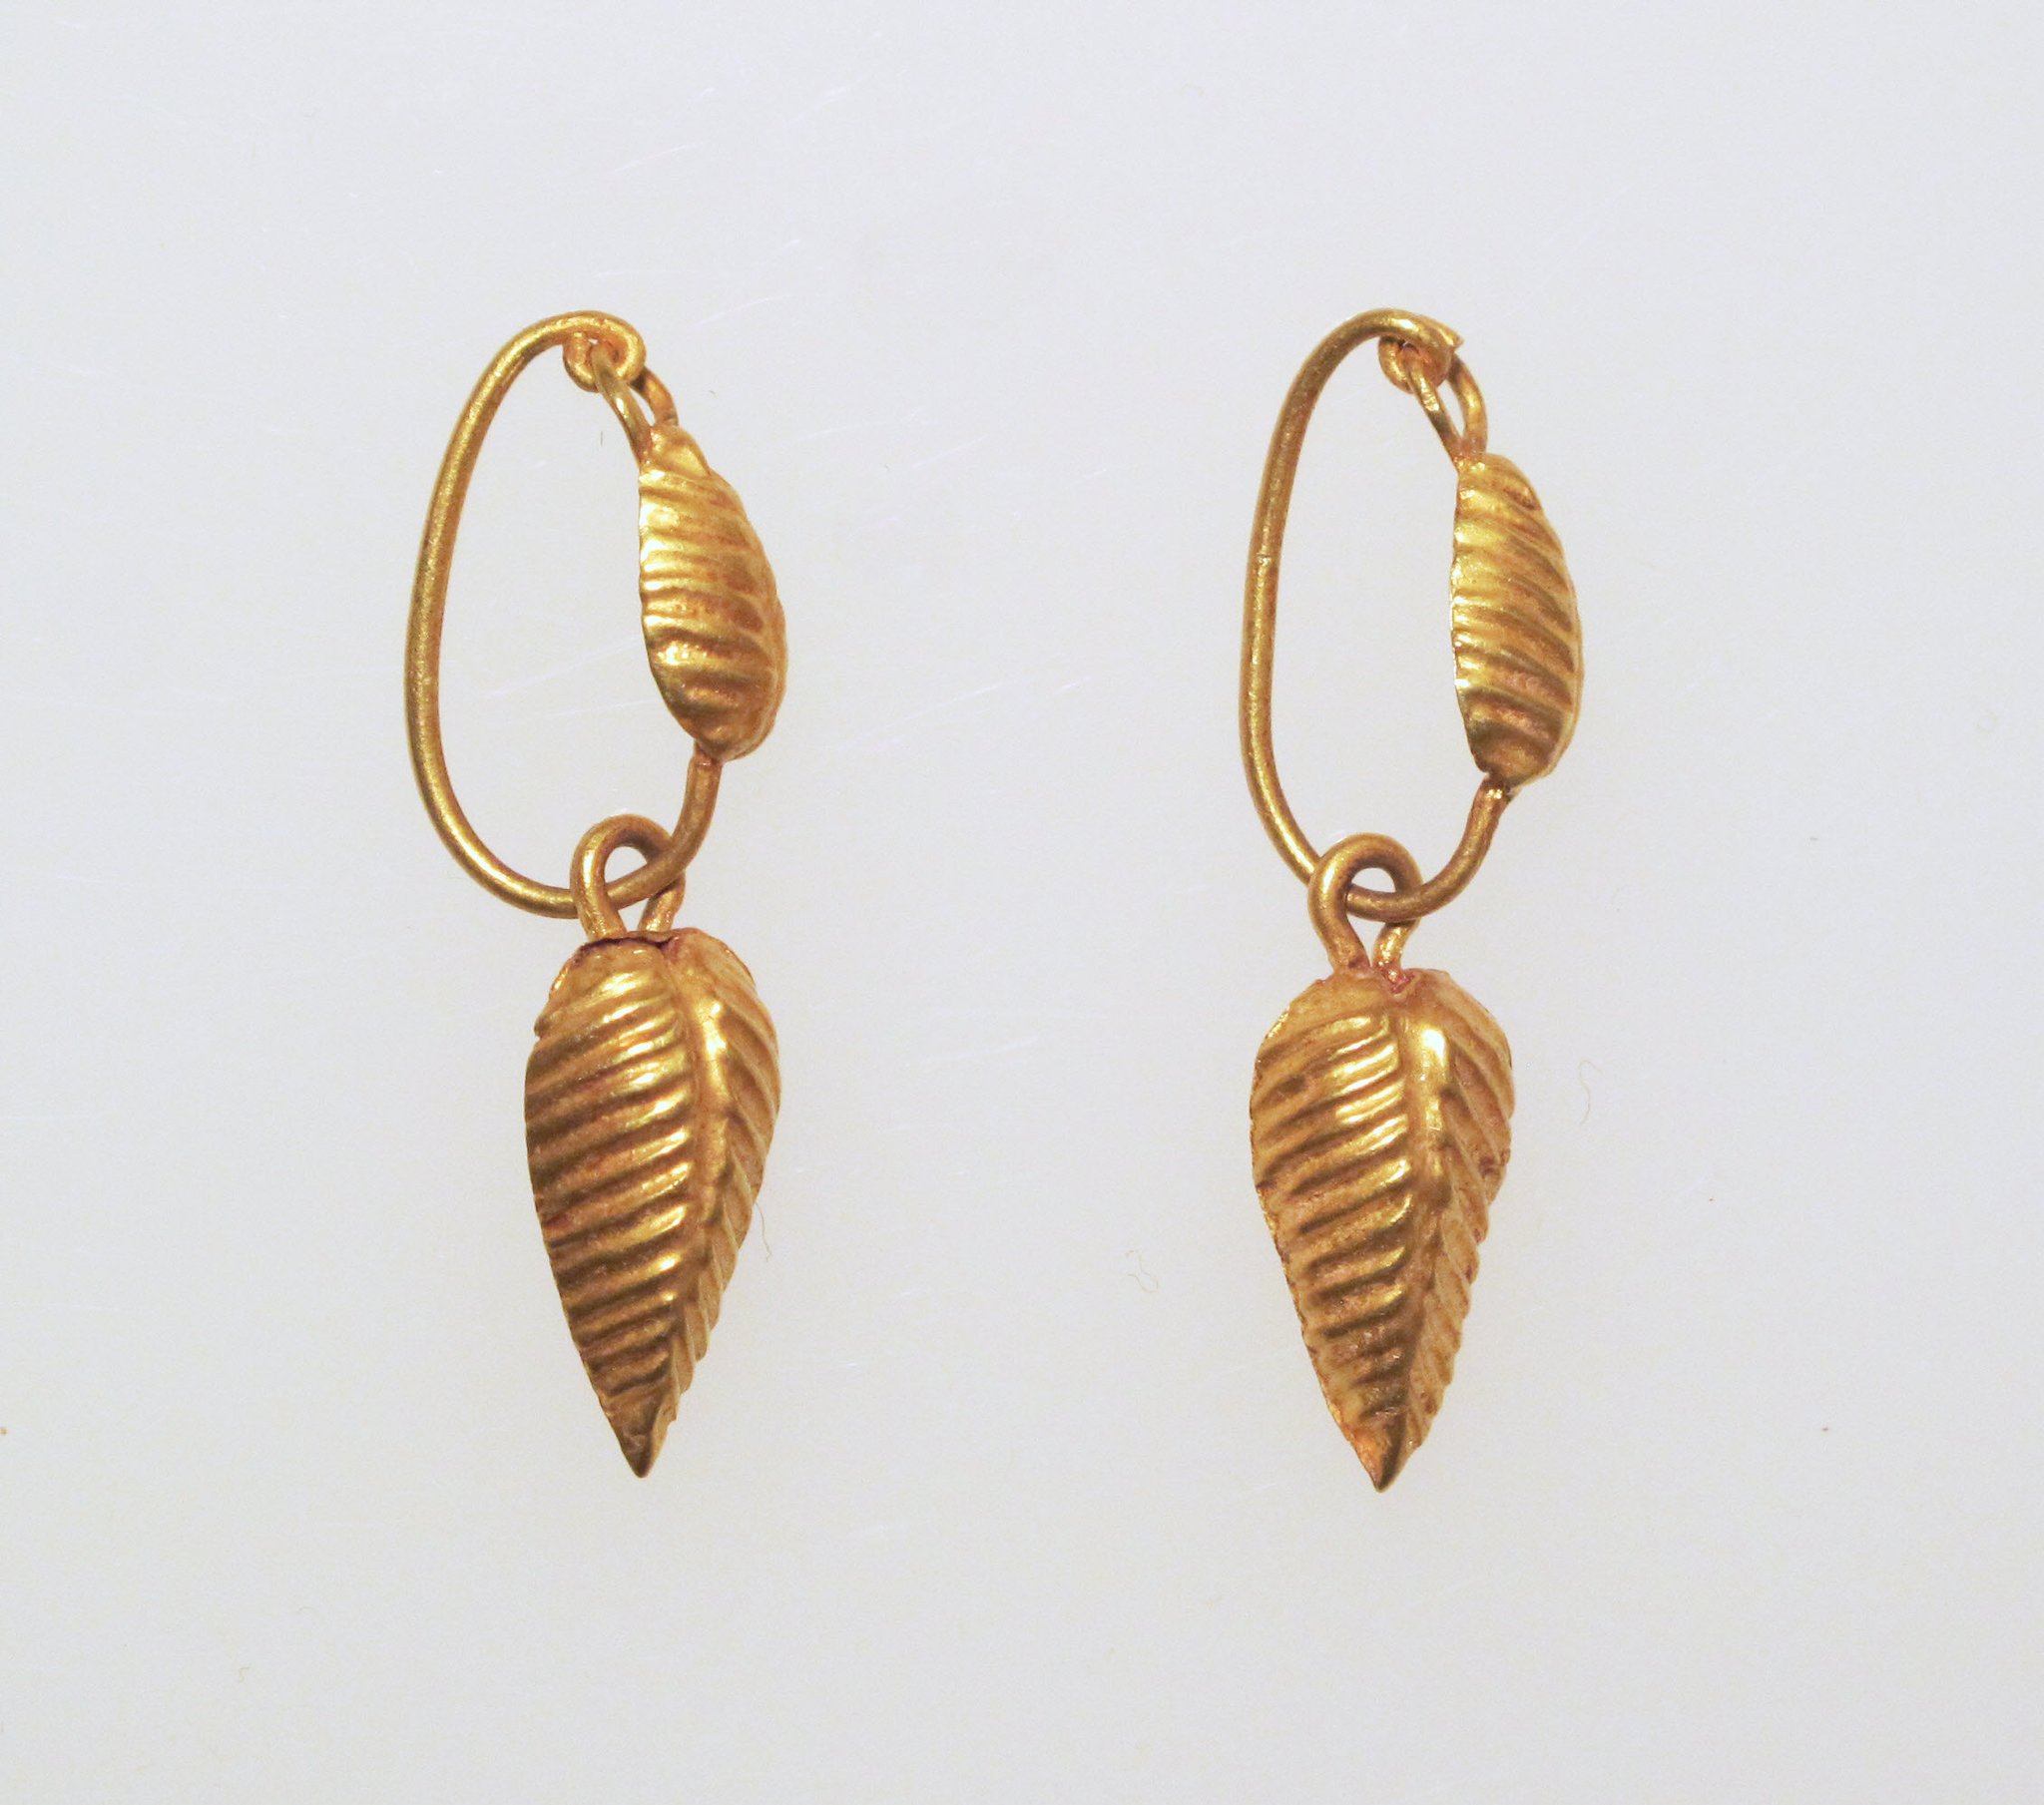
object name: earring with pendant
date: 7000 BCE-330 CE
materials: gold